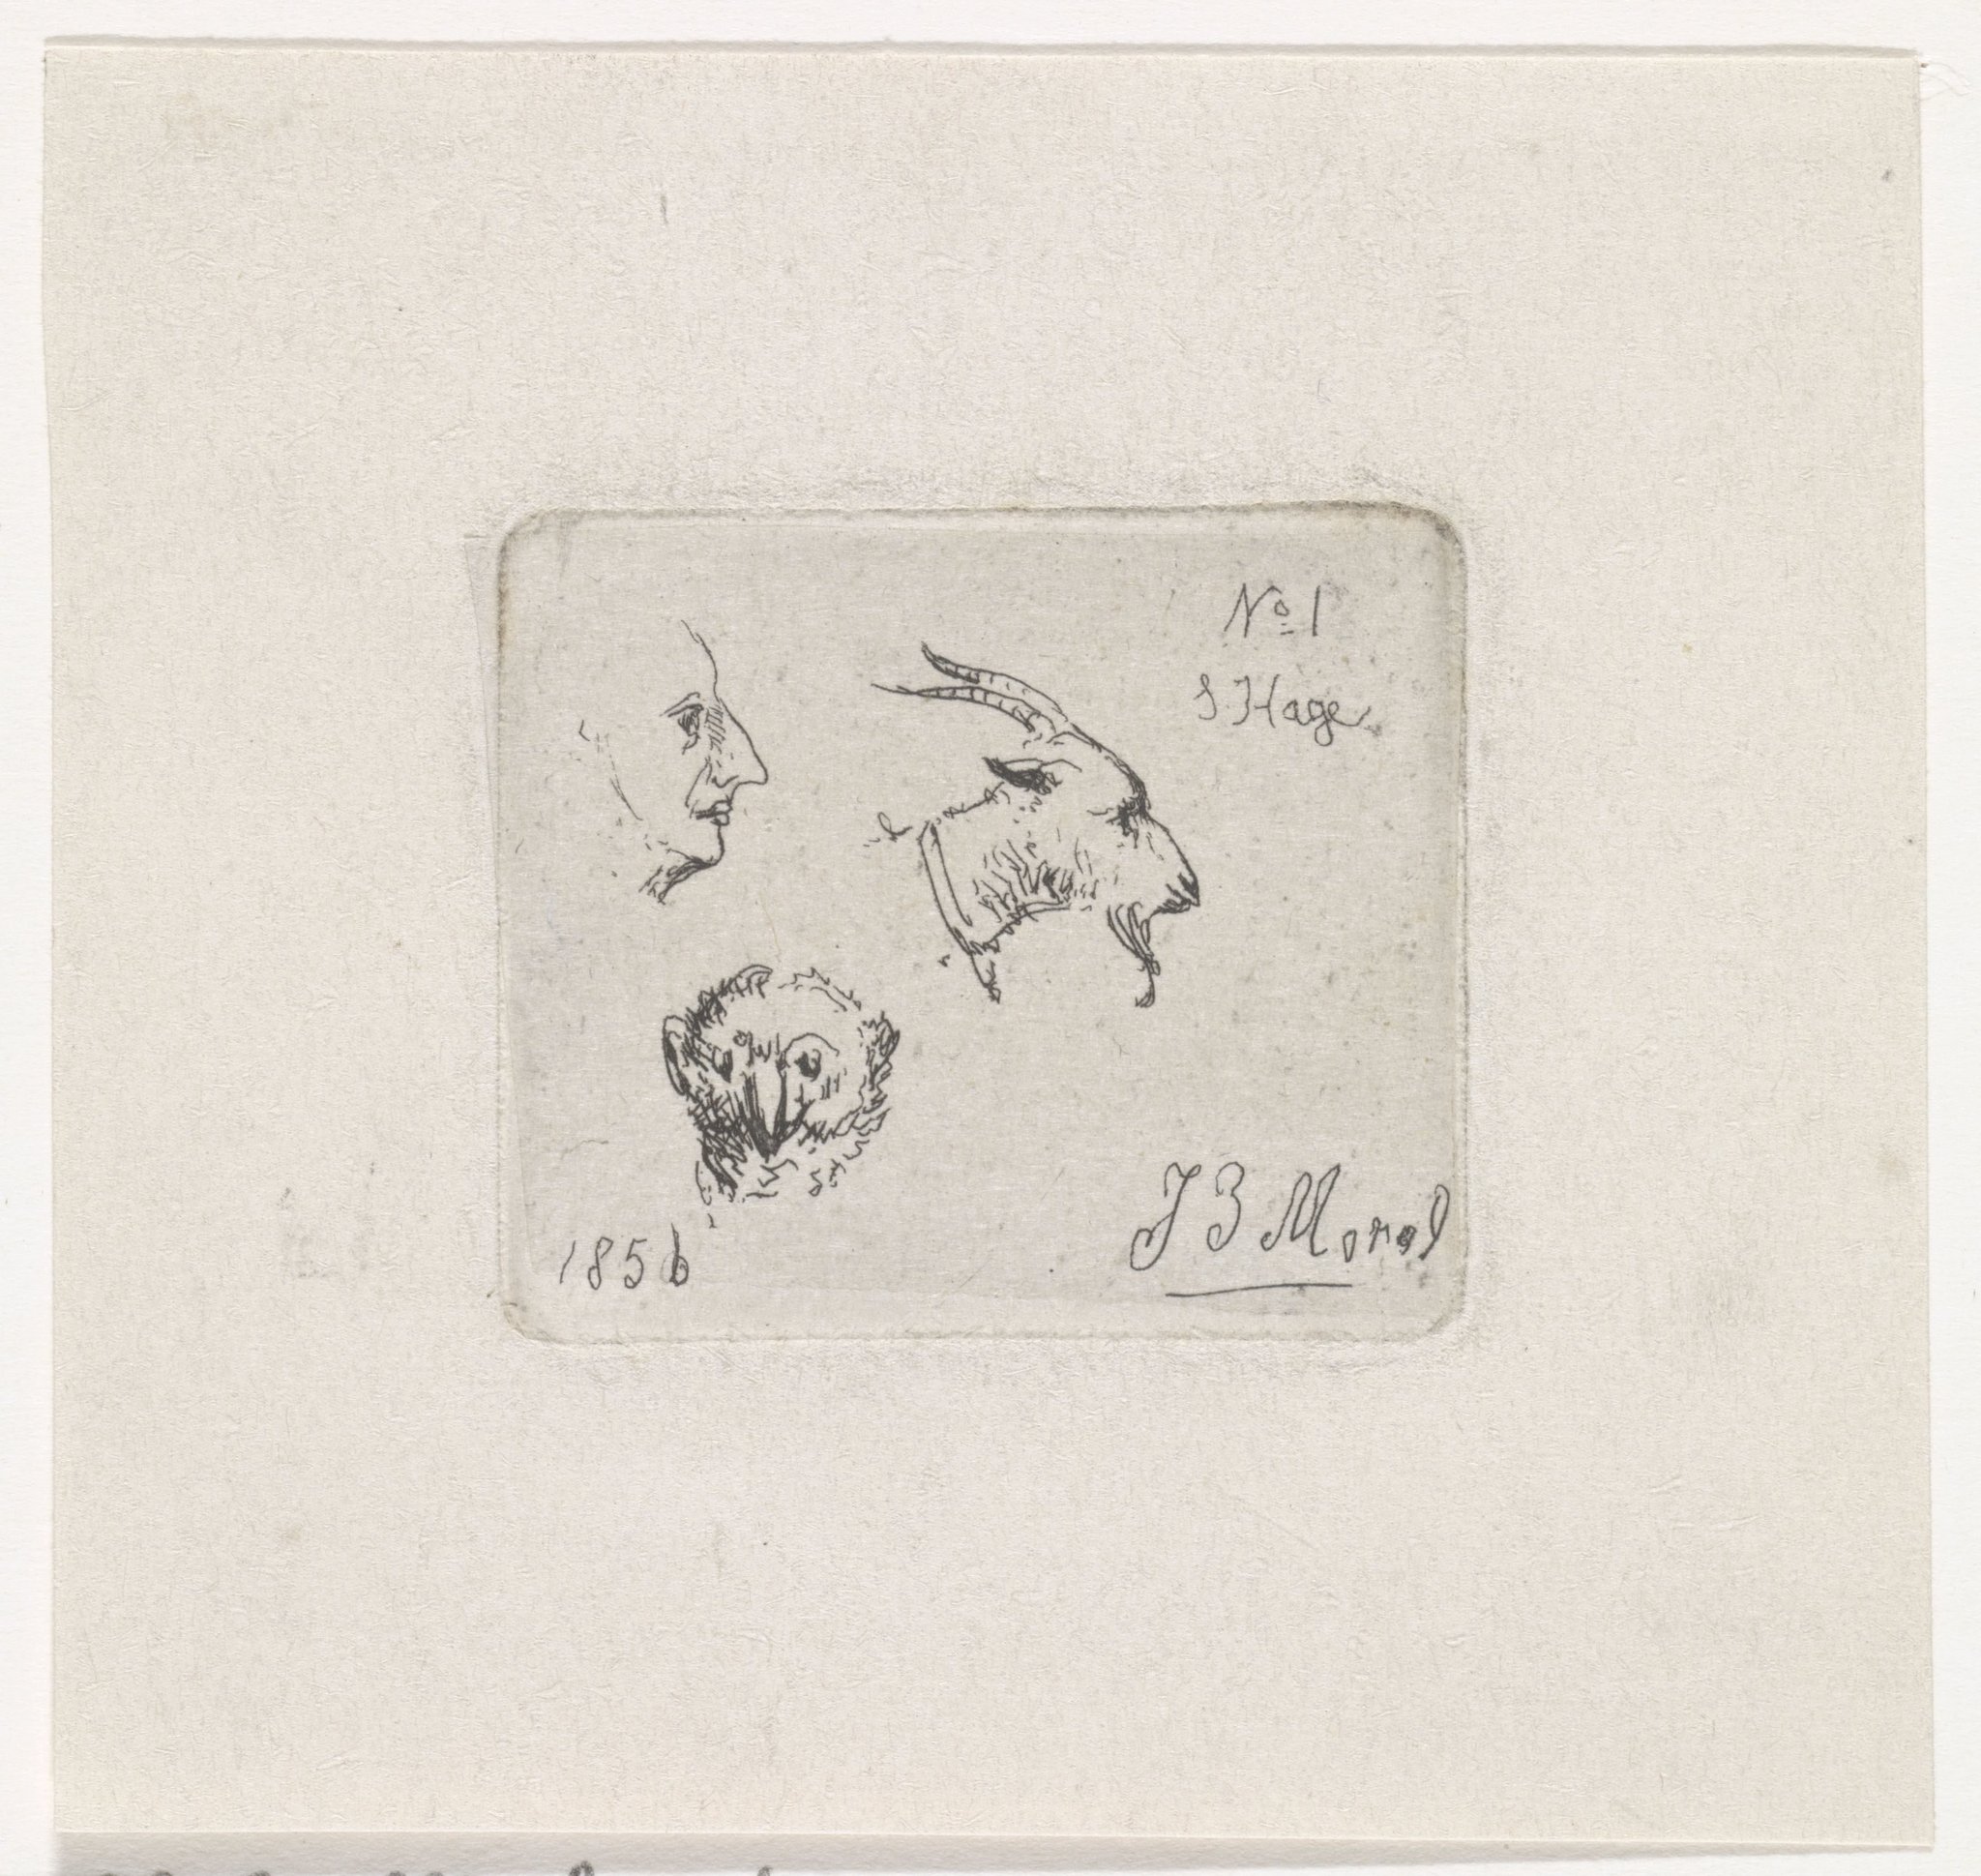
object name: print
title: Manshoofd, geit en uil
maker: jan evert morel (ii)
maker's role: painter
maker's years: 1835-1905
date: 1856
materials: paper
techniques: etching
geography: the hague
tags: adult man, owls, goat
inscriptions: collector's mark: Lugt 2228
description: Een manshoofd en een geitenkop en profil. Onderaan de kop van een uil van voren.